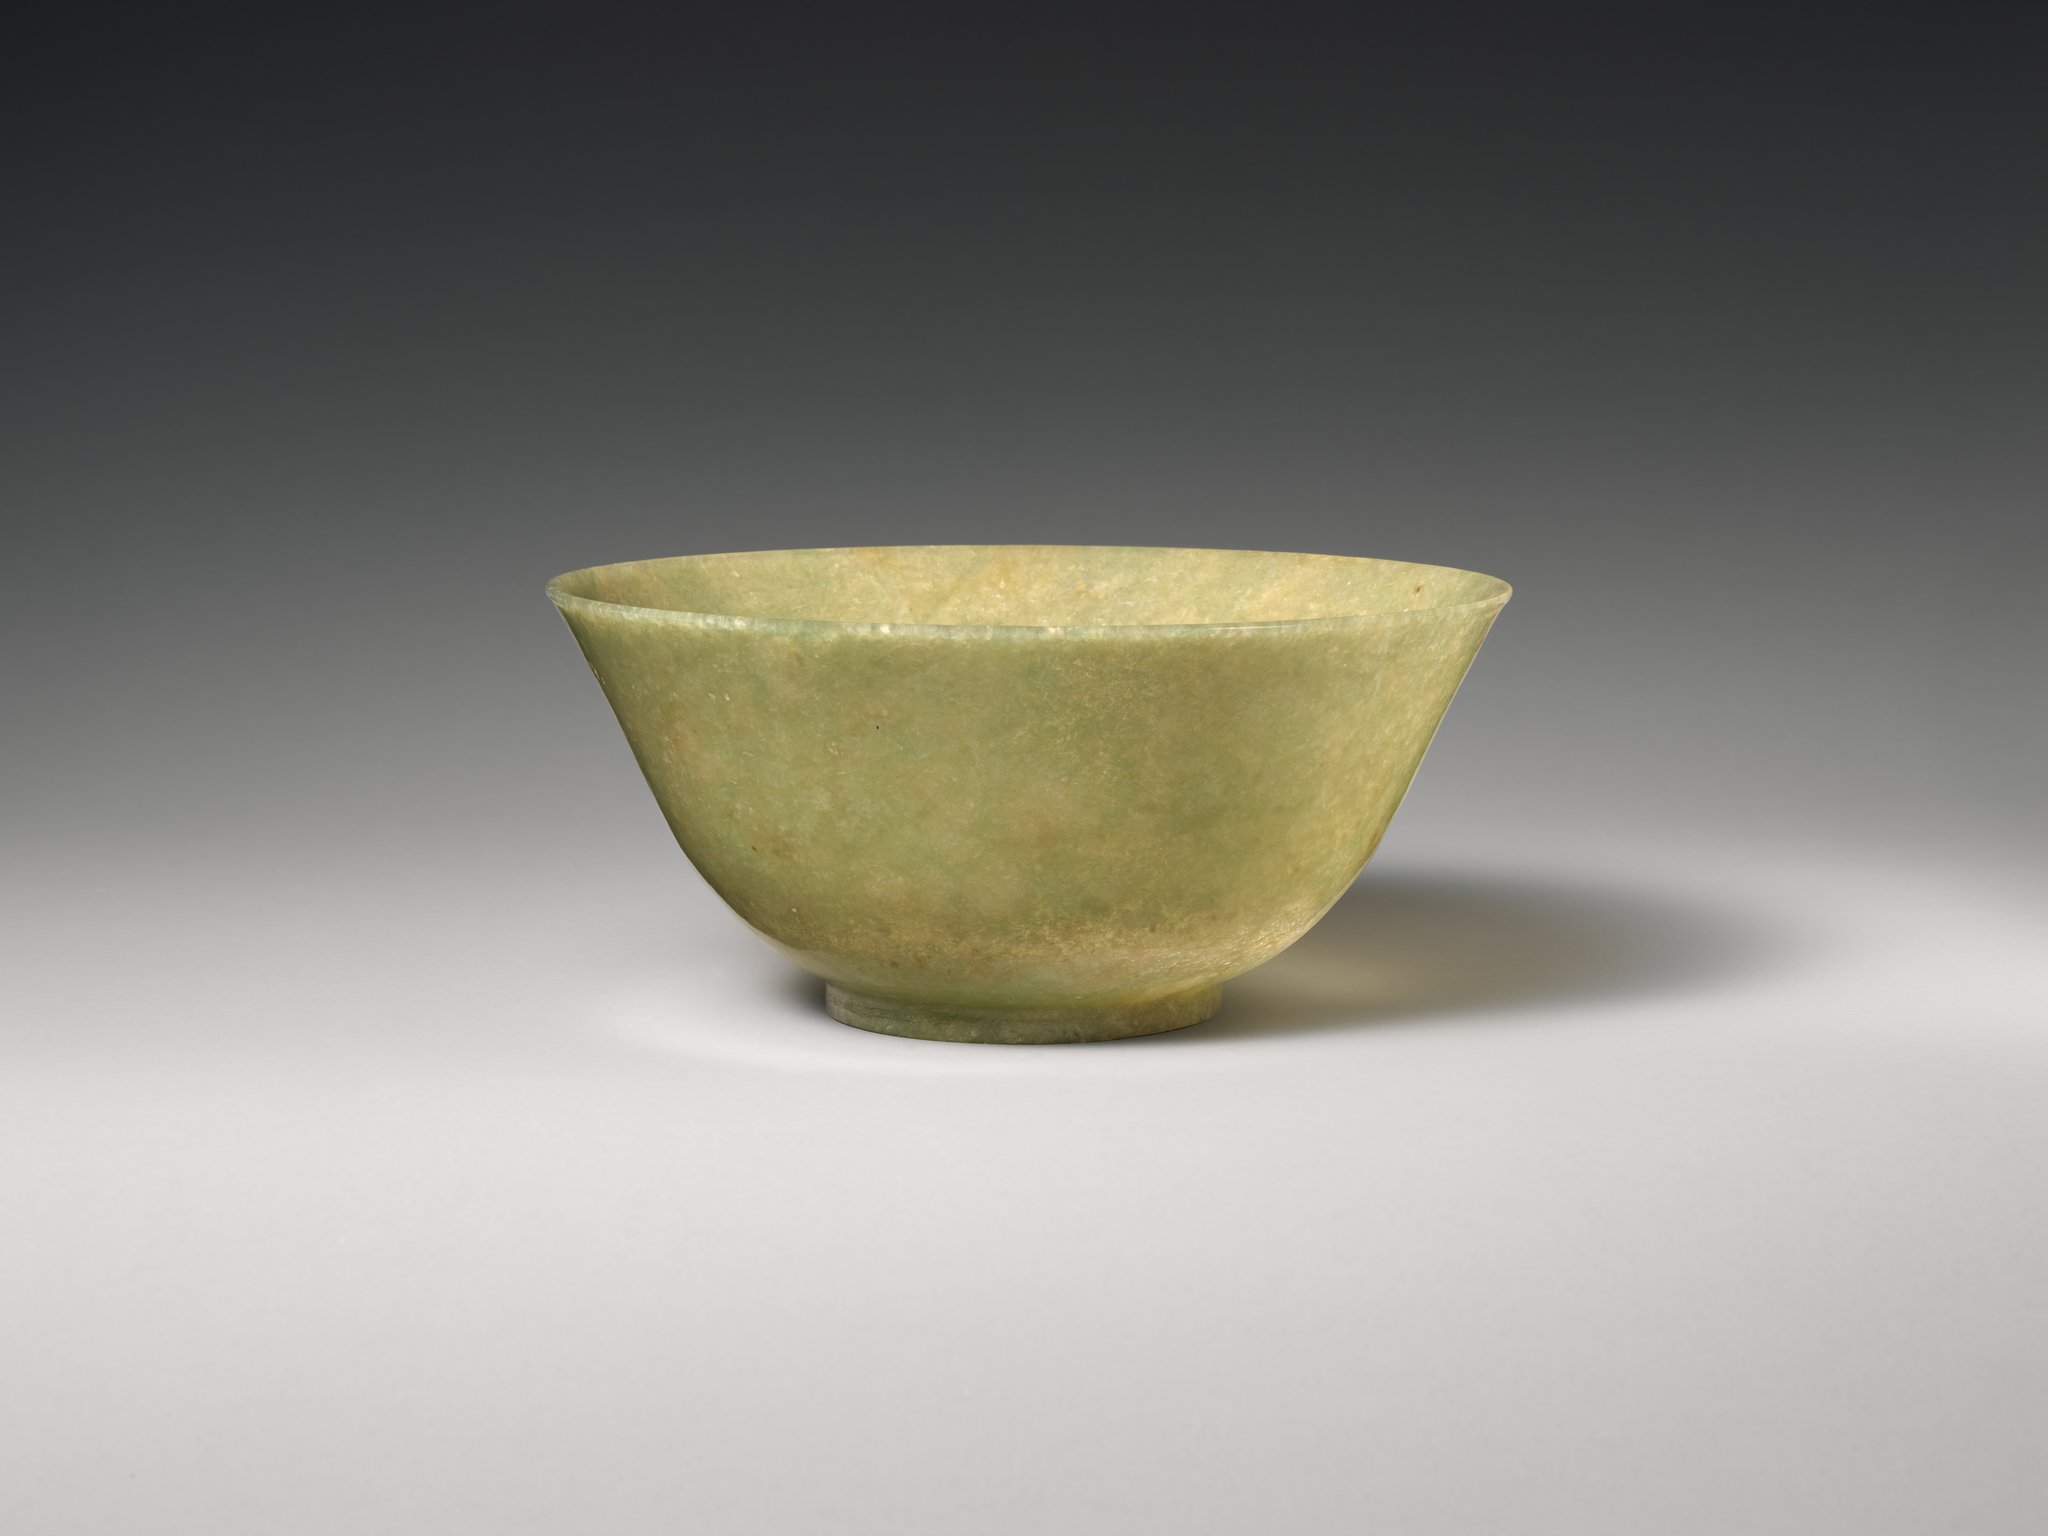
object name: bowl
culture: chinese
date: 1662-1722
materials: jade